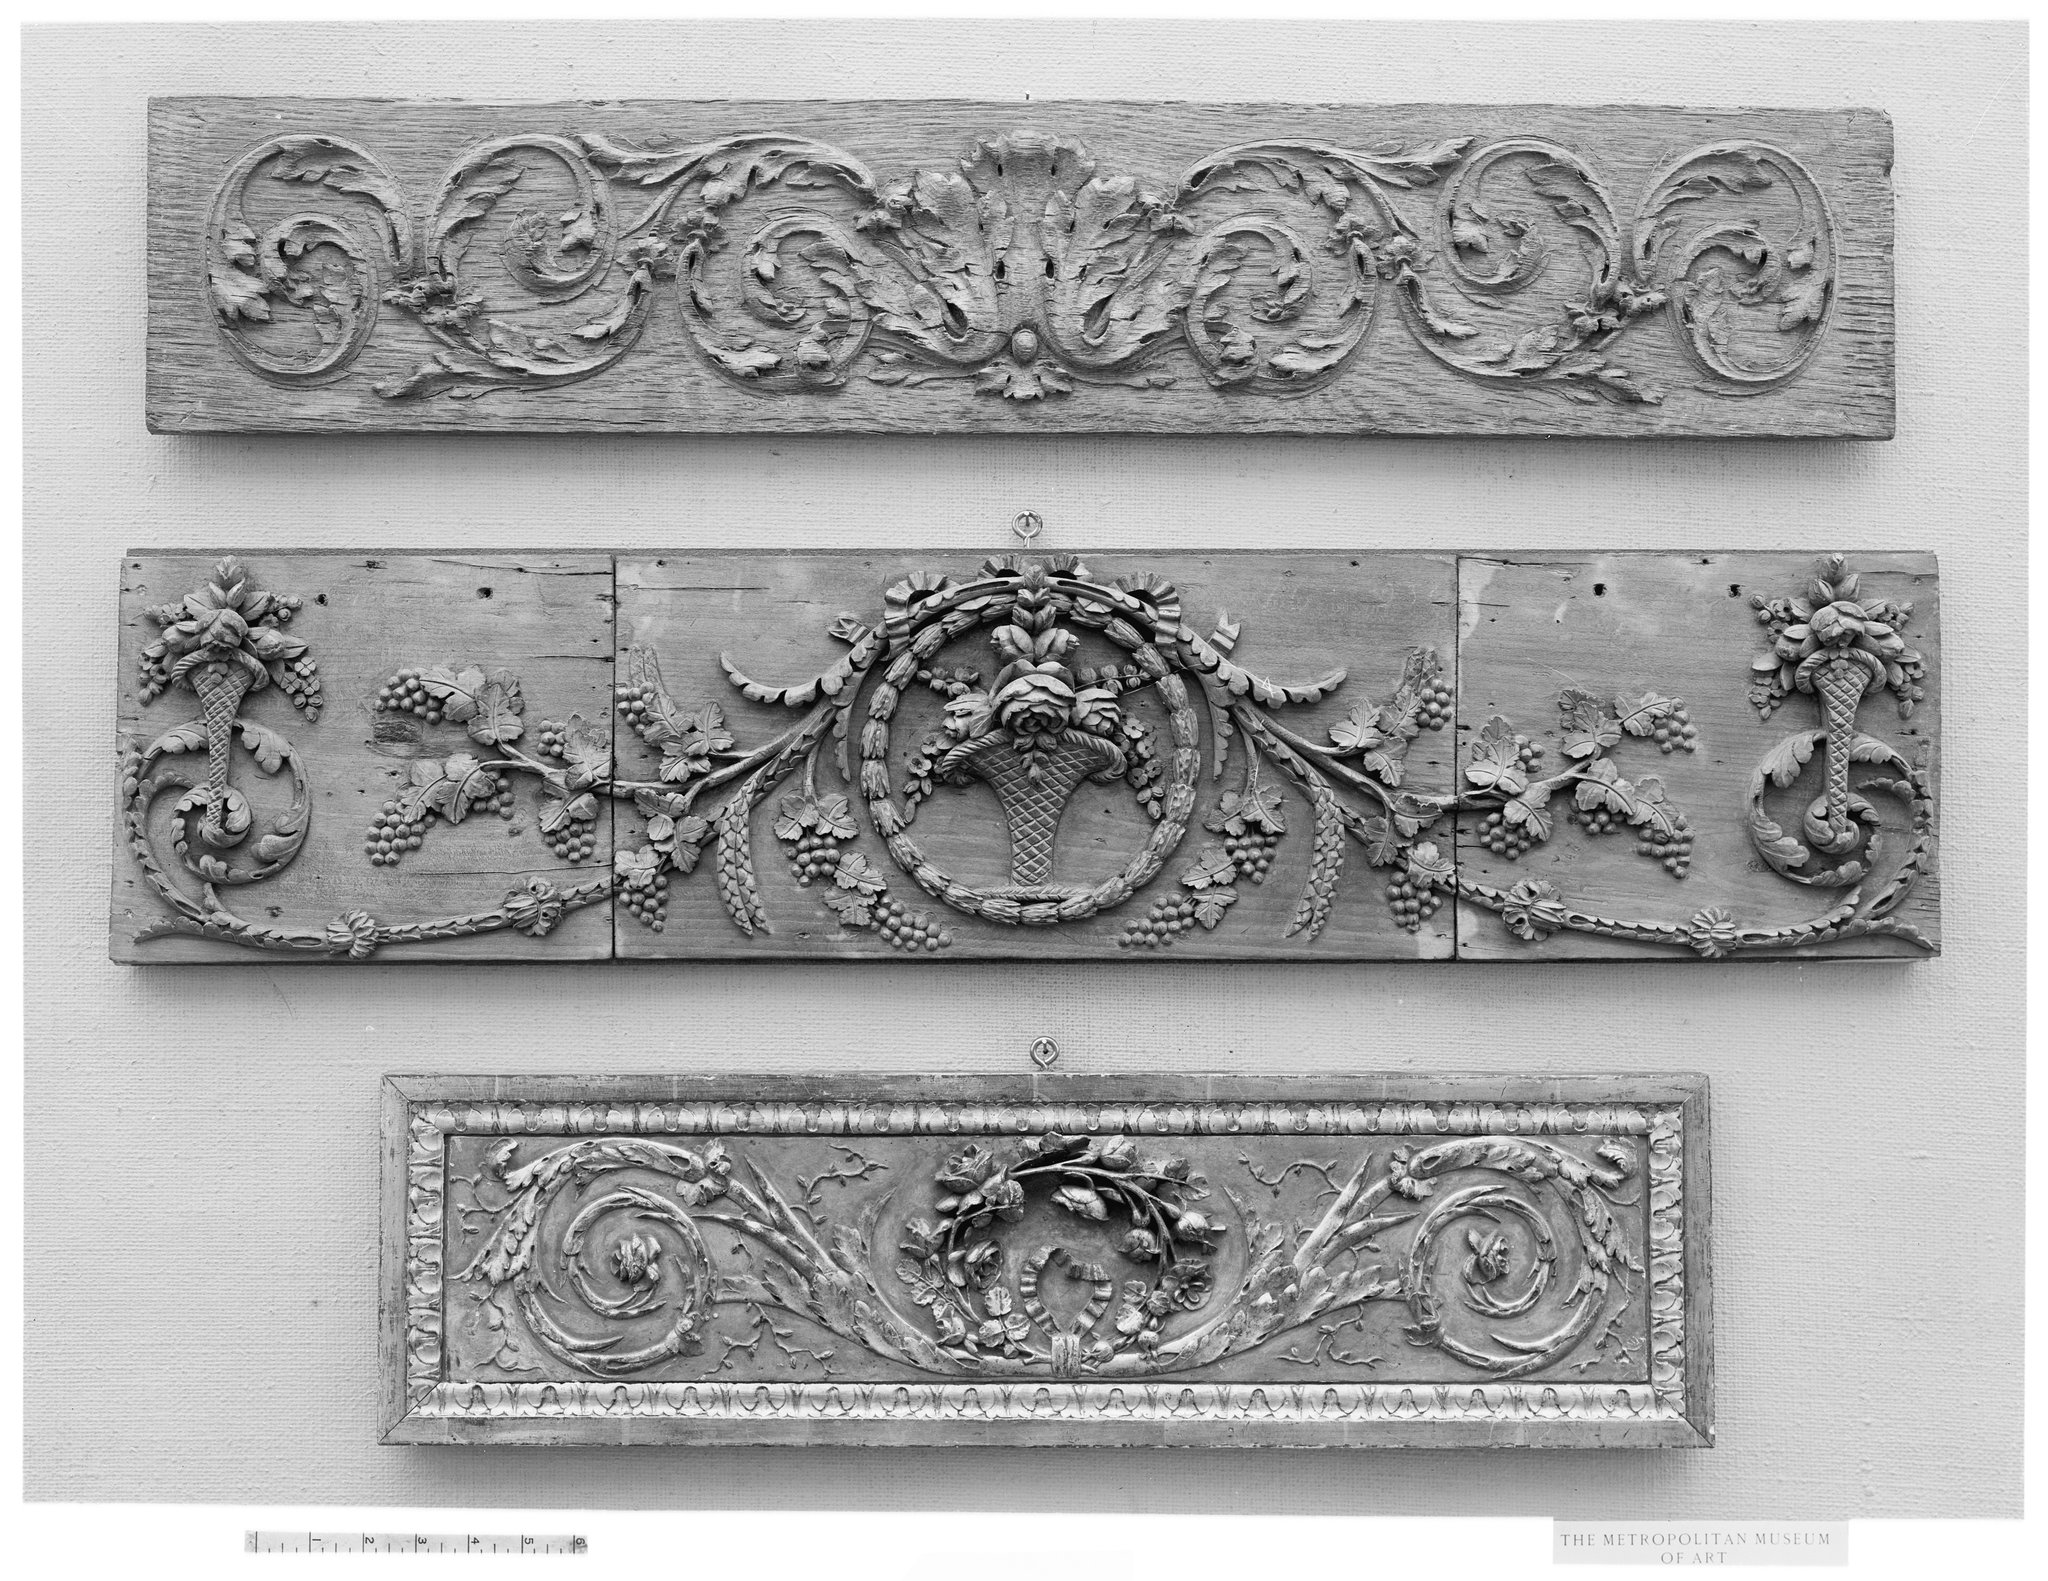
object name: frieze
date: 1701-1800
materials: wood, wax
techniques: polish